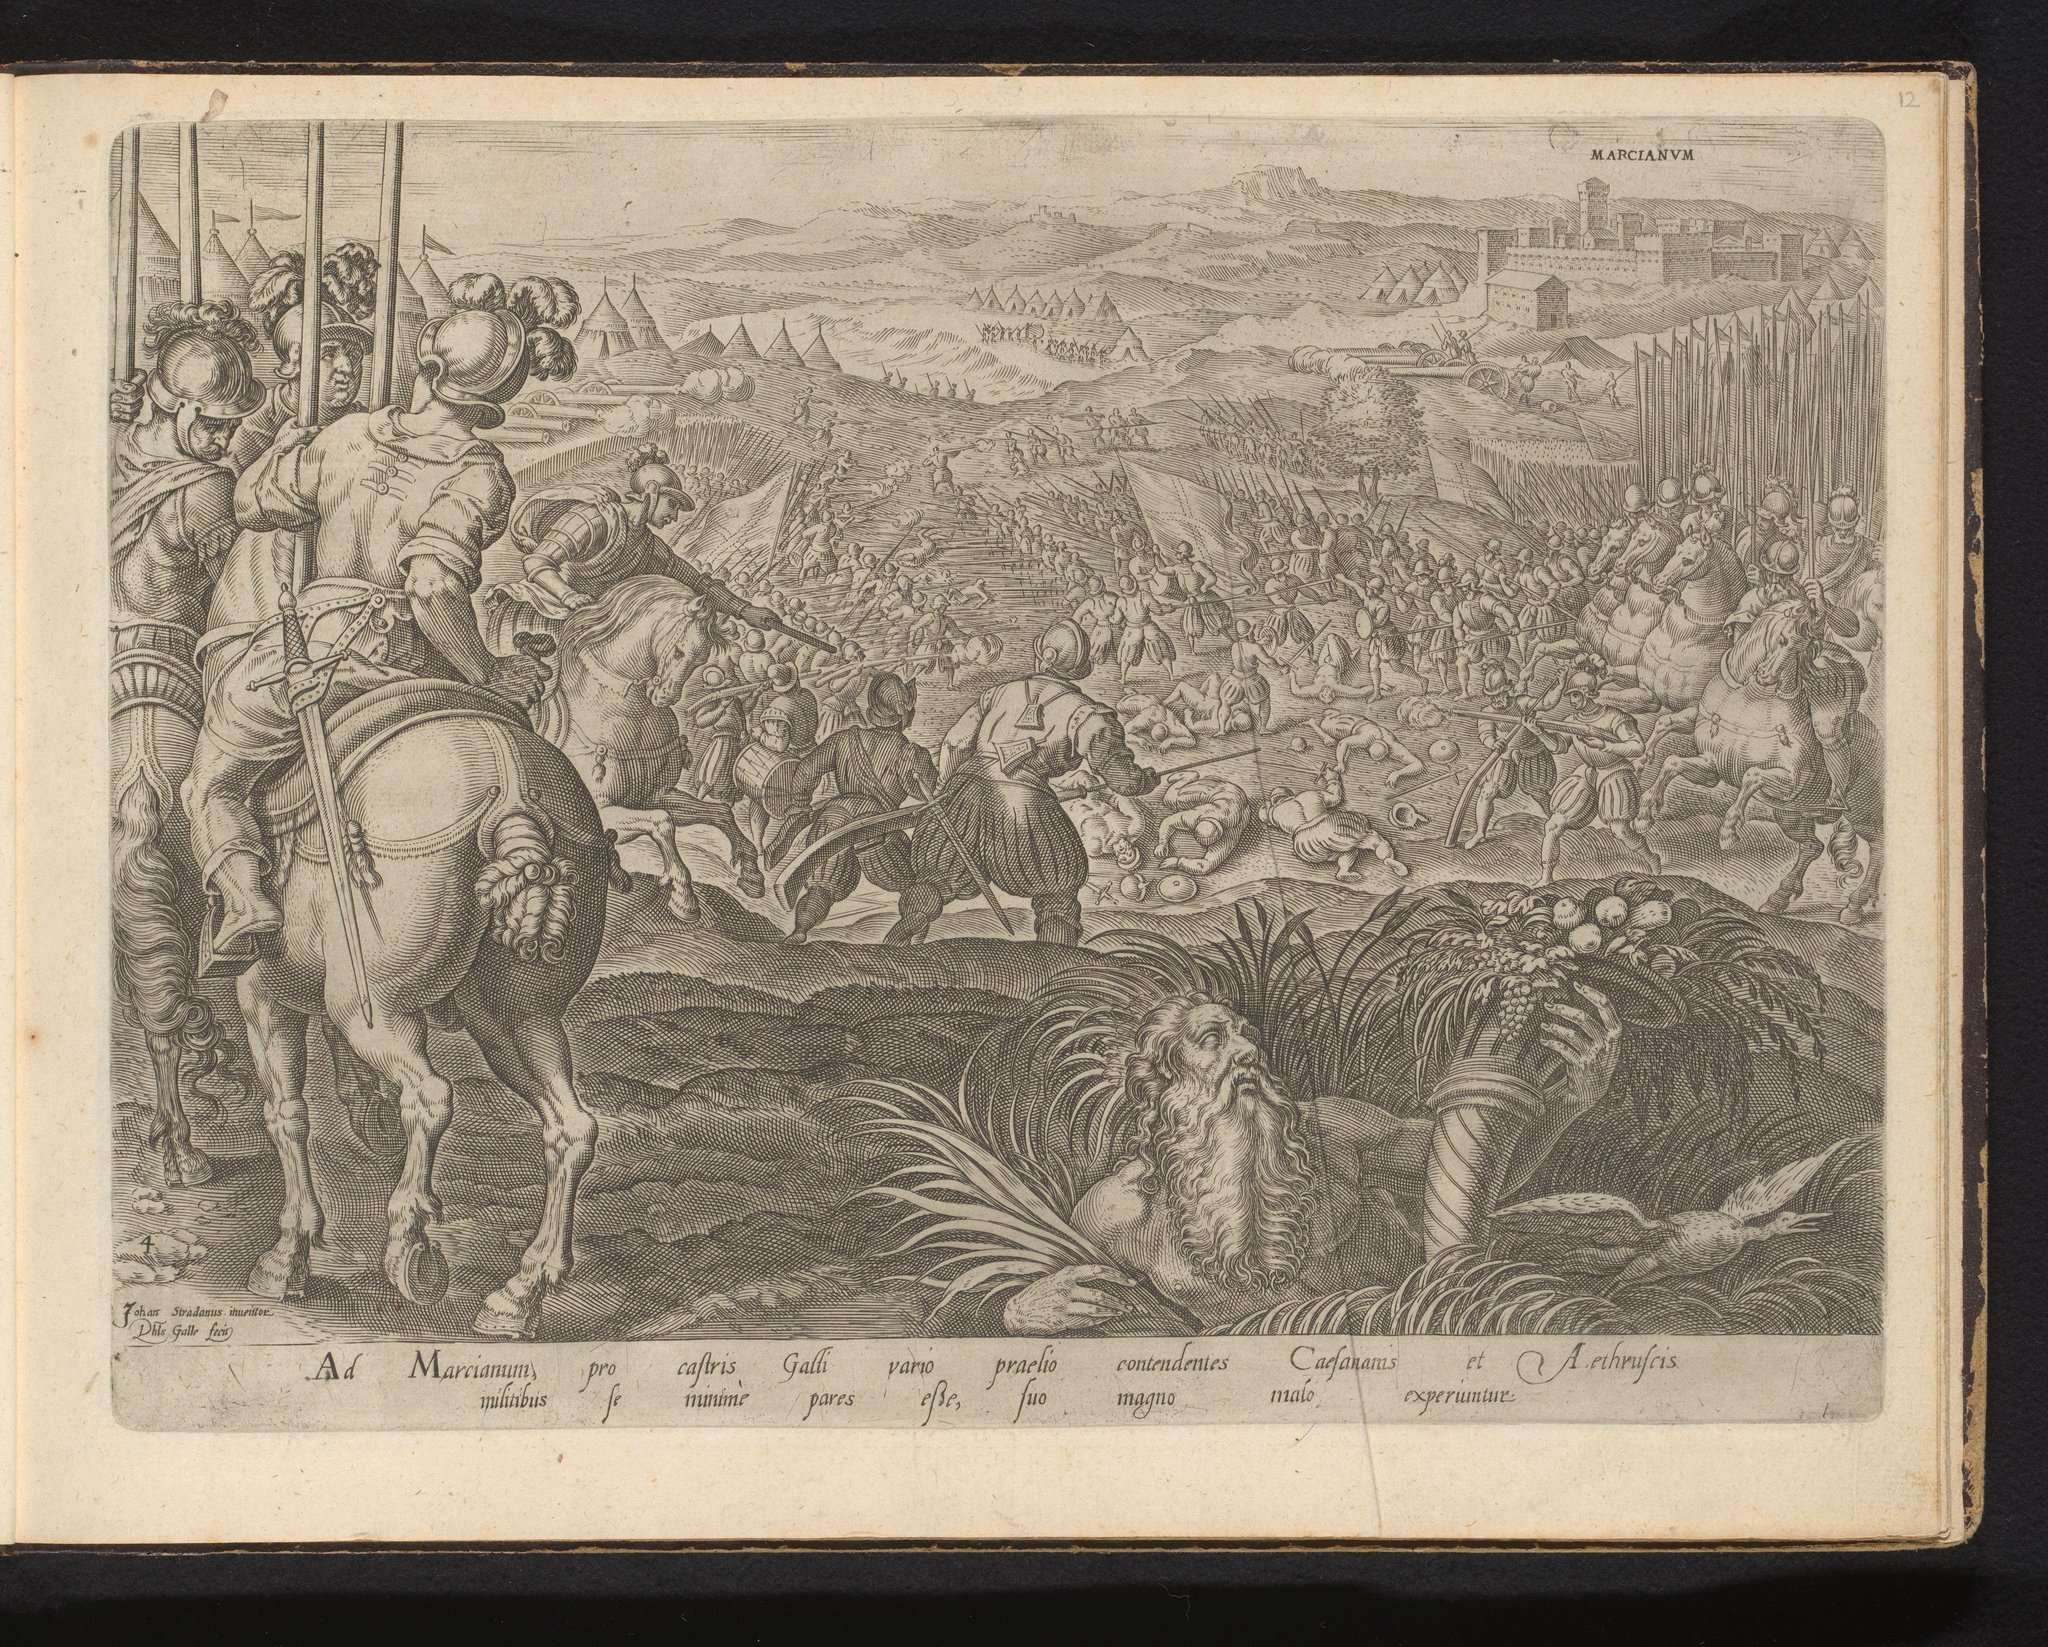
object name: print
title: Mediceae Familiae rerum feliciter gestarum victoriae et triumphi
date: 1583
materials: paper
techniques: engraving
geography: antwerp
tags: cosimo i de' medici, pietro strozzi, 'cornucopia', horn of plenty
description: De veldslag bij Marciano in 1554. Het leger van de' Medici onder leiding van Gian Giacomo de' Medici tegenover het Franse leger van Pietro Strozzi. In de achtergrond de stad Marciano. In de voorgrond een riviergod met een cornucopia. In de ondermarge twee regels tekst in het Latijn en genummerd 4. De prent maakt deel uit van een album.